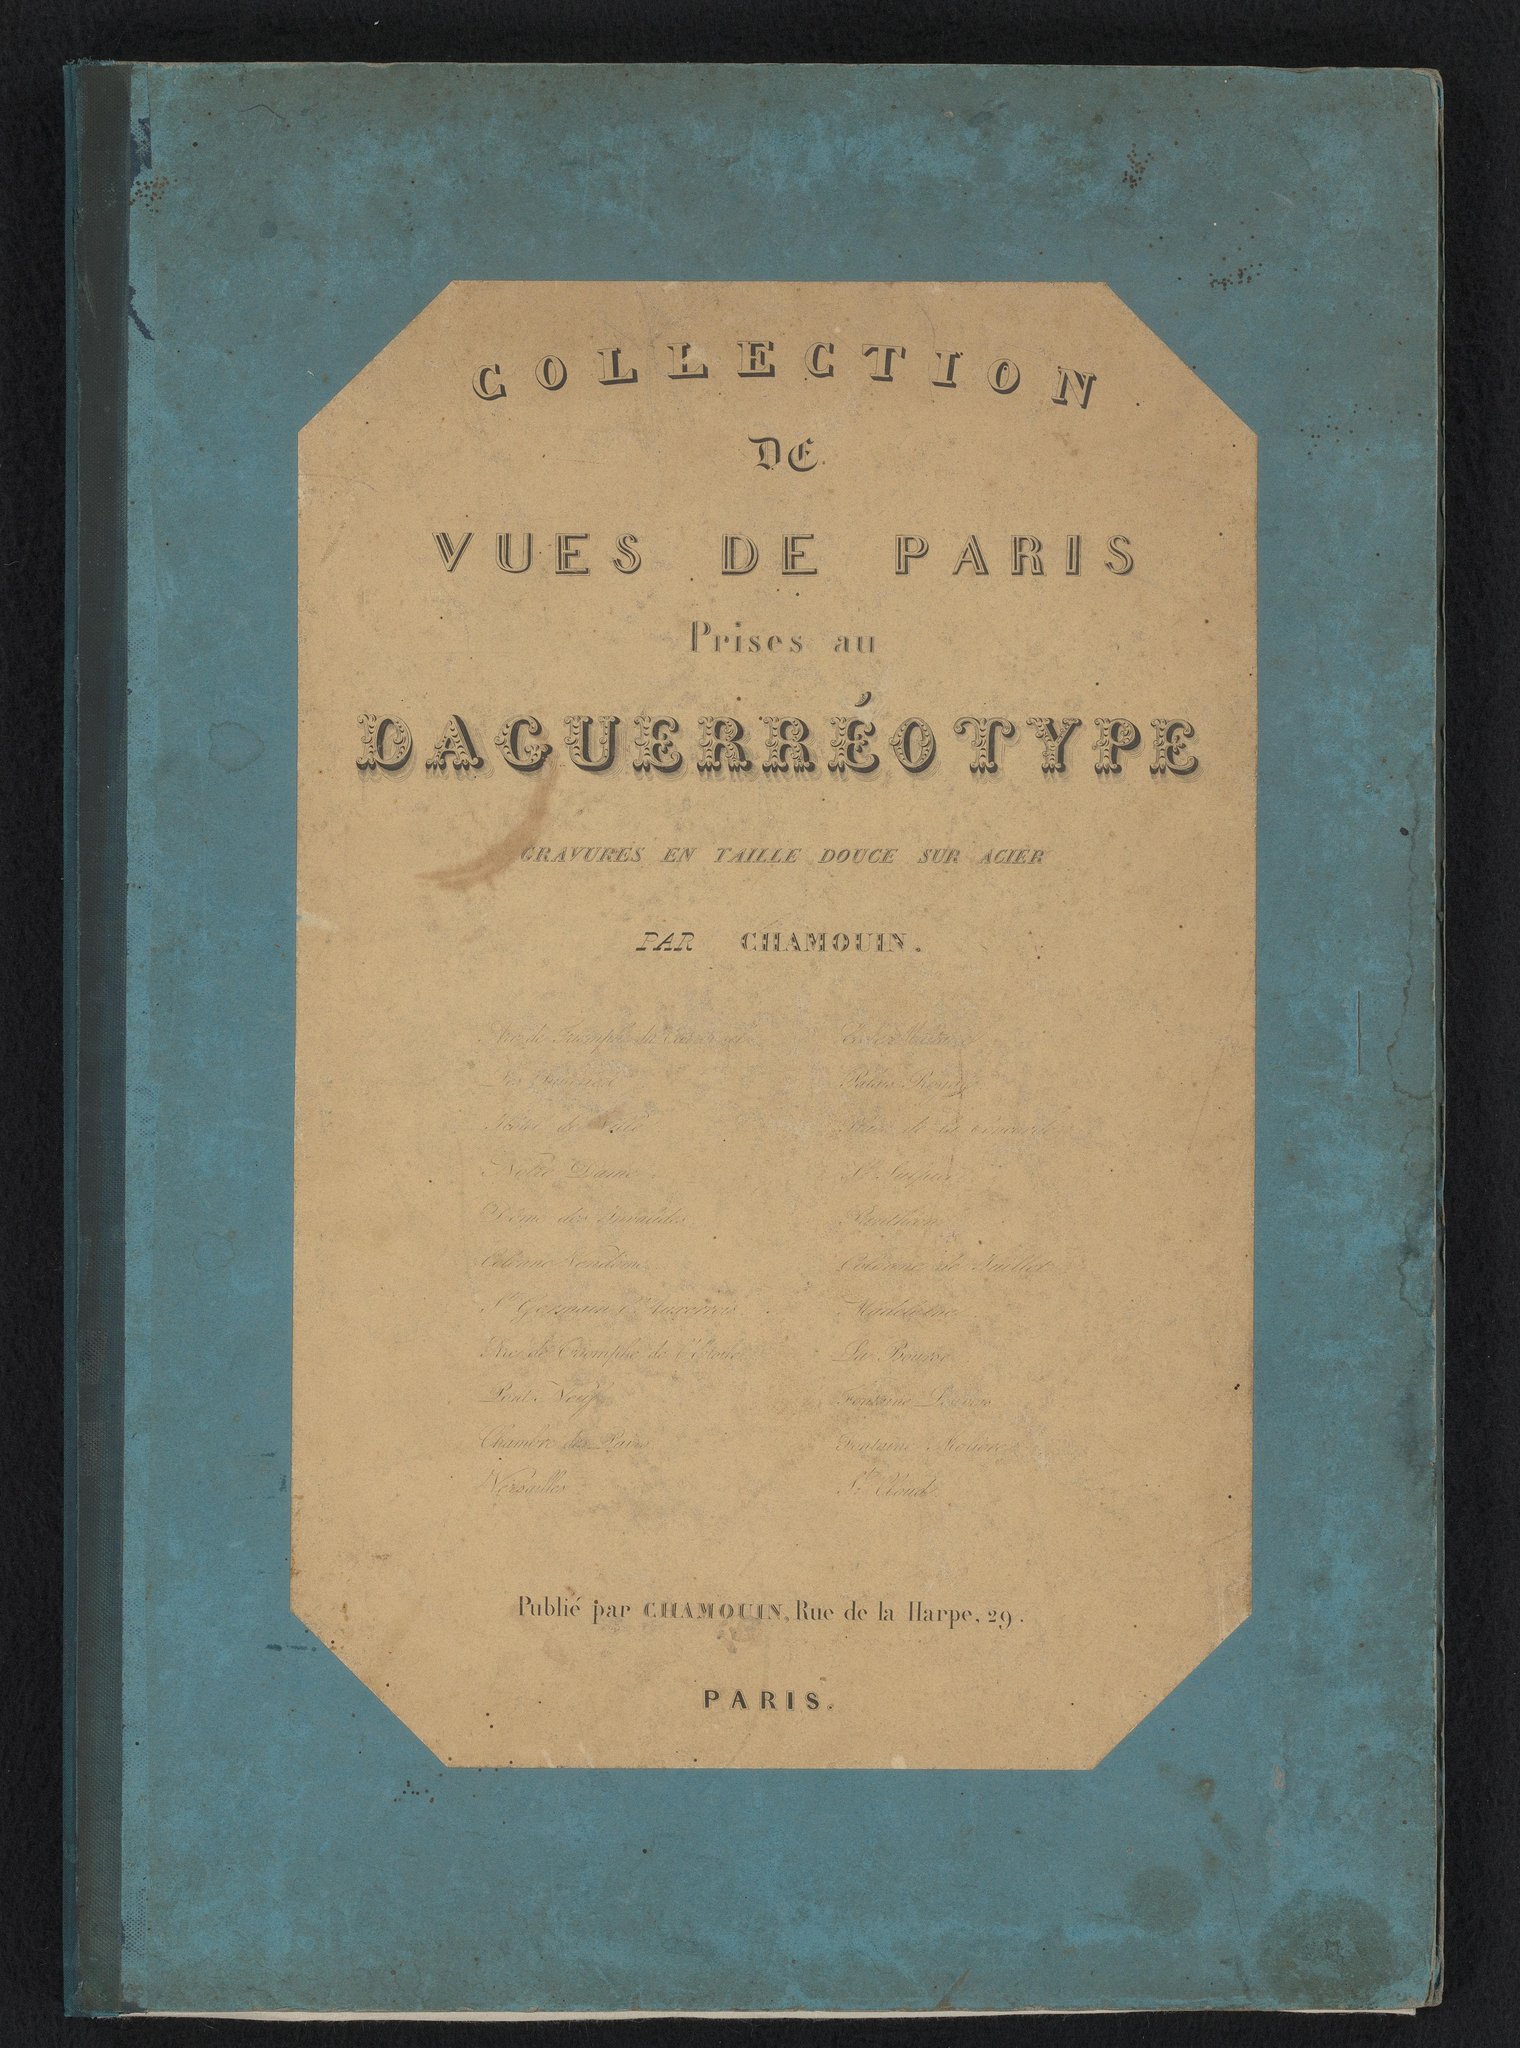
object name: wrapper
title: Collection de vues de Paris : prises au daguerréotype : gravures en taille douce sur acier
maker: jean baptiste marie chamouin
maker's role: publisher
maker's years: 1768-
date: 1850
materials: cardboard, linen, paper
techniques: lithograph, engraving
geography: paris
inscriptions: inscription: ‘DIENST VERSPREIDE/ RIJKSKOLLEKTIES/ KAERNESTRAAT 3/ '-GRAVENHAGE/ TEL. 070 / 63 89 63/ Kunstenaar:/ Titel:/ Koll.:/ Inv. kat. :/ Inv. nr. : F01071/ Maten:’, inscription: ‘Paris/ f3503487 u32’, inscription: ‘1845/ zie Stengen p. 149/ zie [...] p. 190/op veiling gekocht 13/6/61 zie 192 Zw[...] 170-’